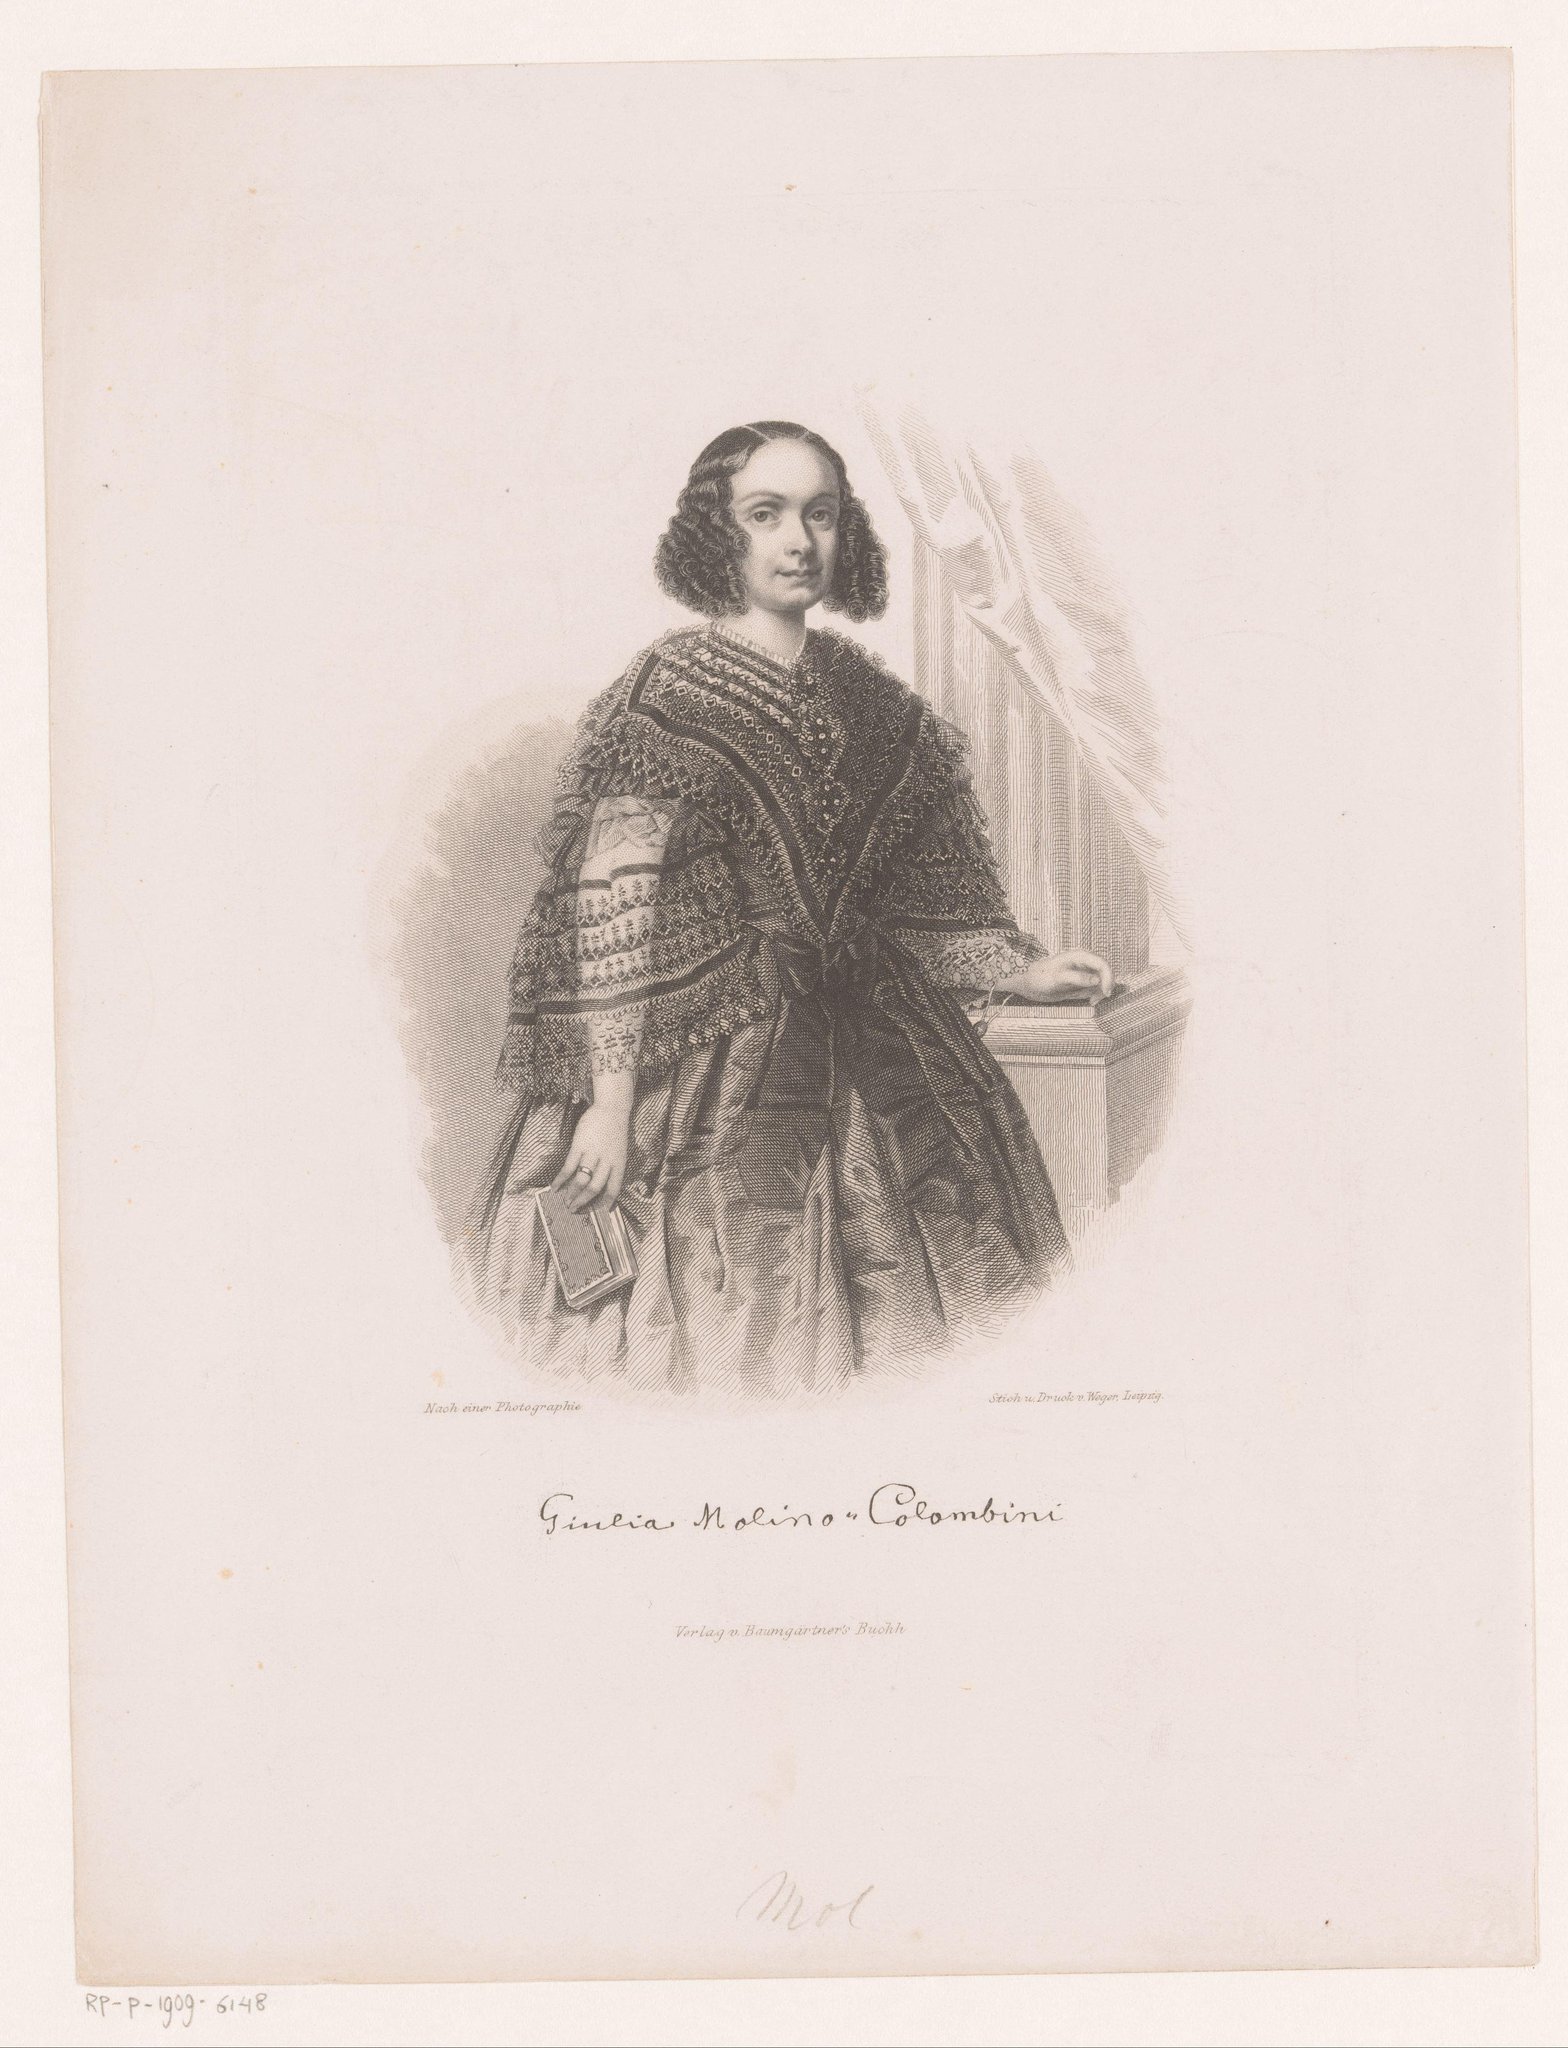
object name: print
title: Portret van Giulia Molino-Colombini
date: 1849-1892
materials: paper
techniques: engraving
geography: leipzig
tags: historical persons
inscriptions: collector's mark: Lugt 2228